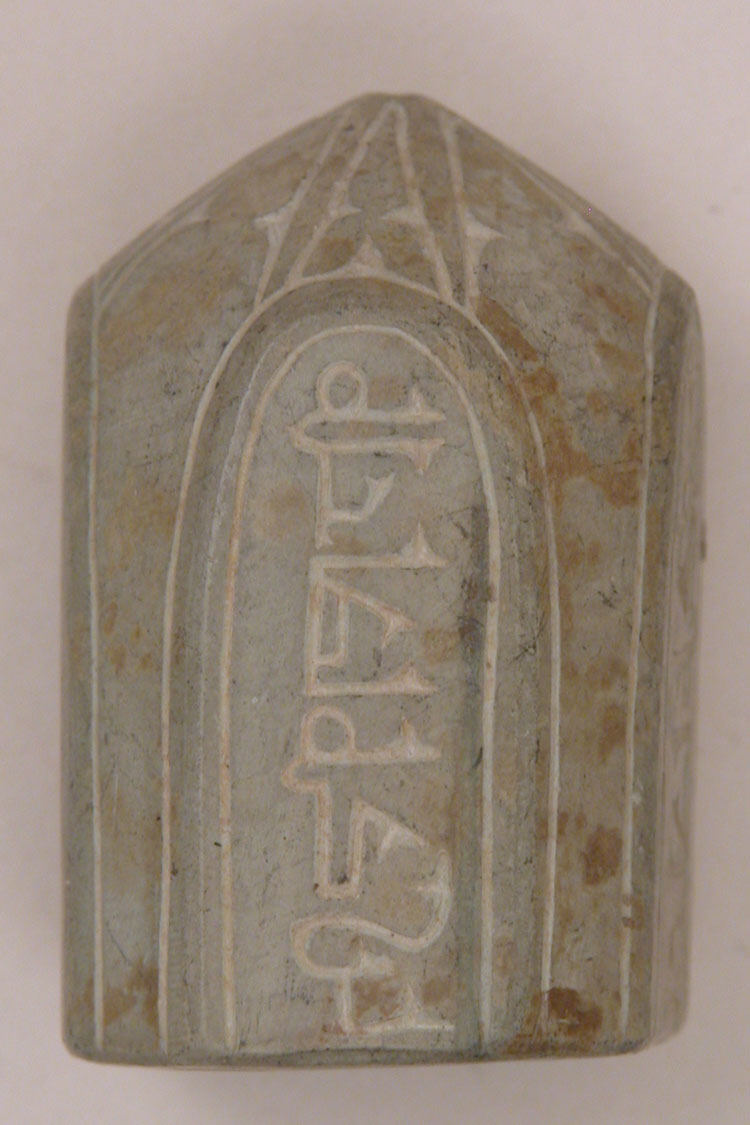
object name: chess piece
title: Chess Piece, Pawn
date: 801-1100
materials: stone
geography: western islamic lands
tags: chess